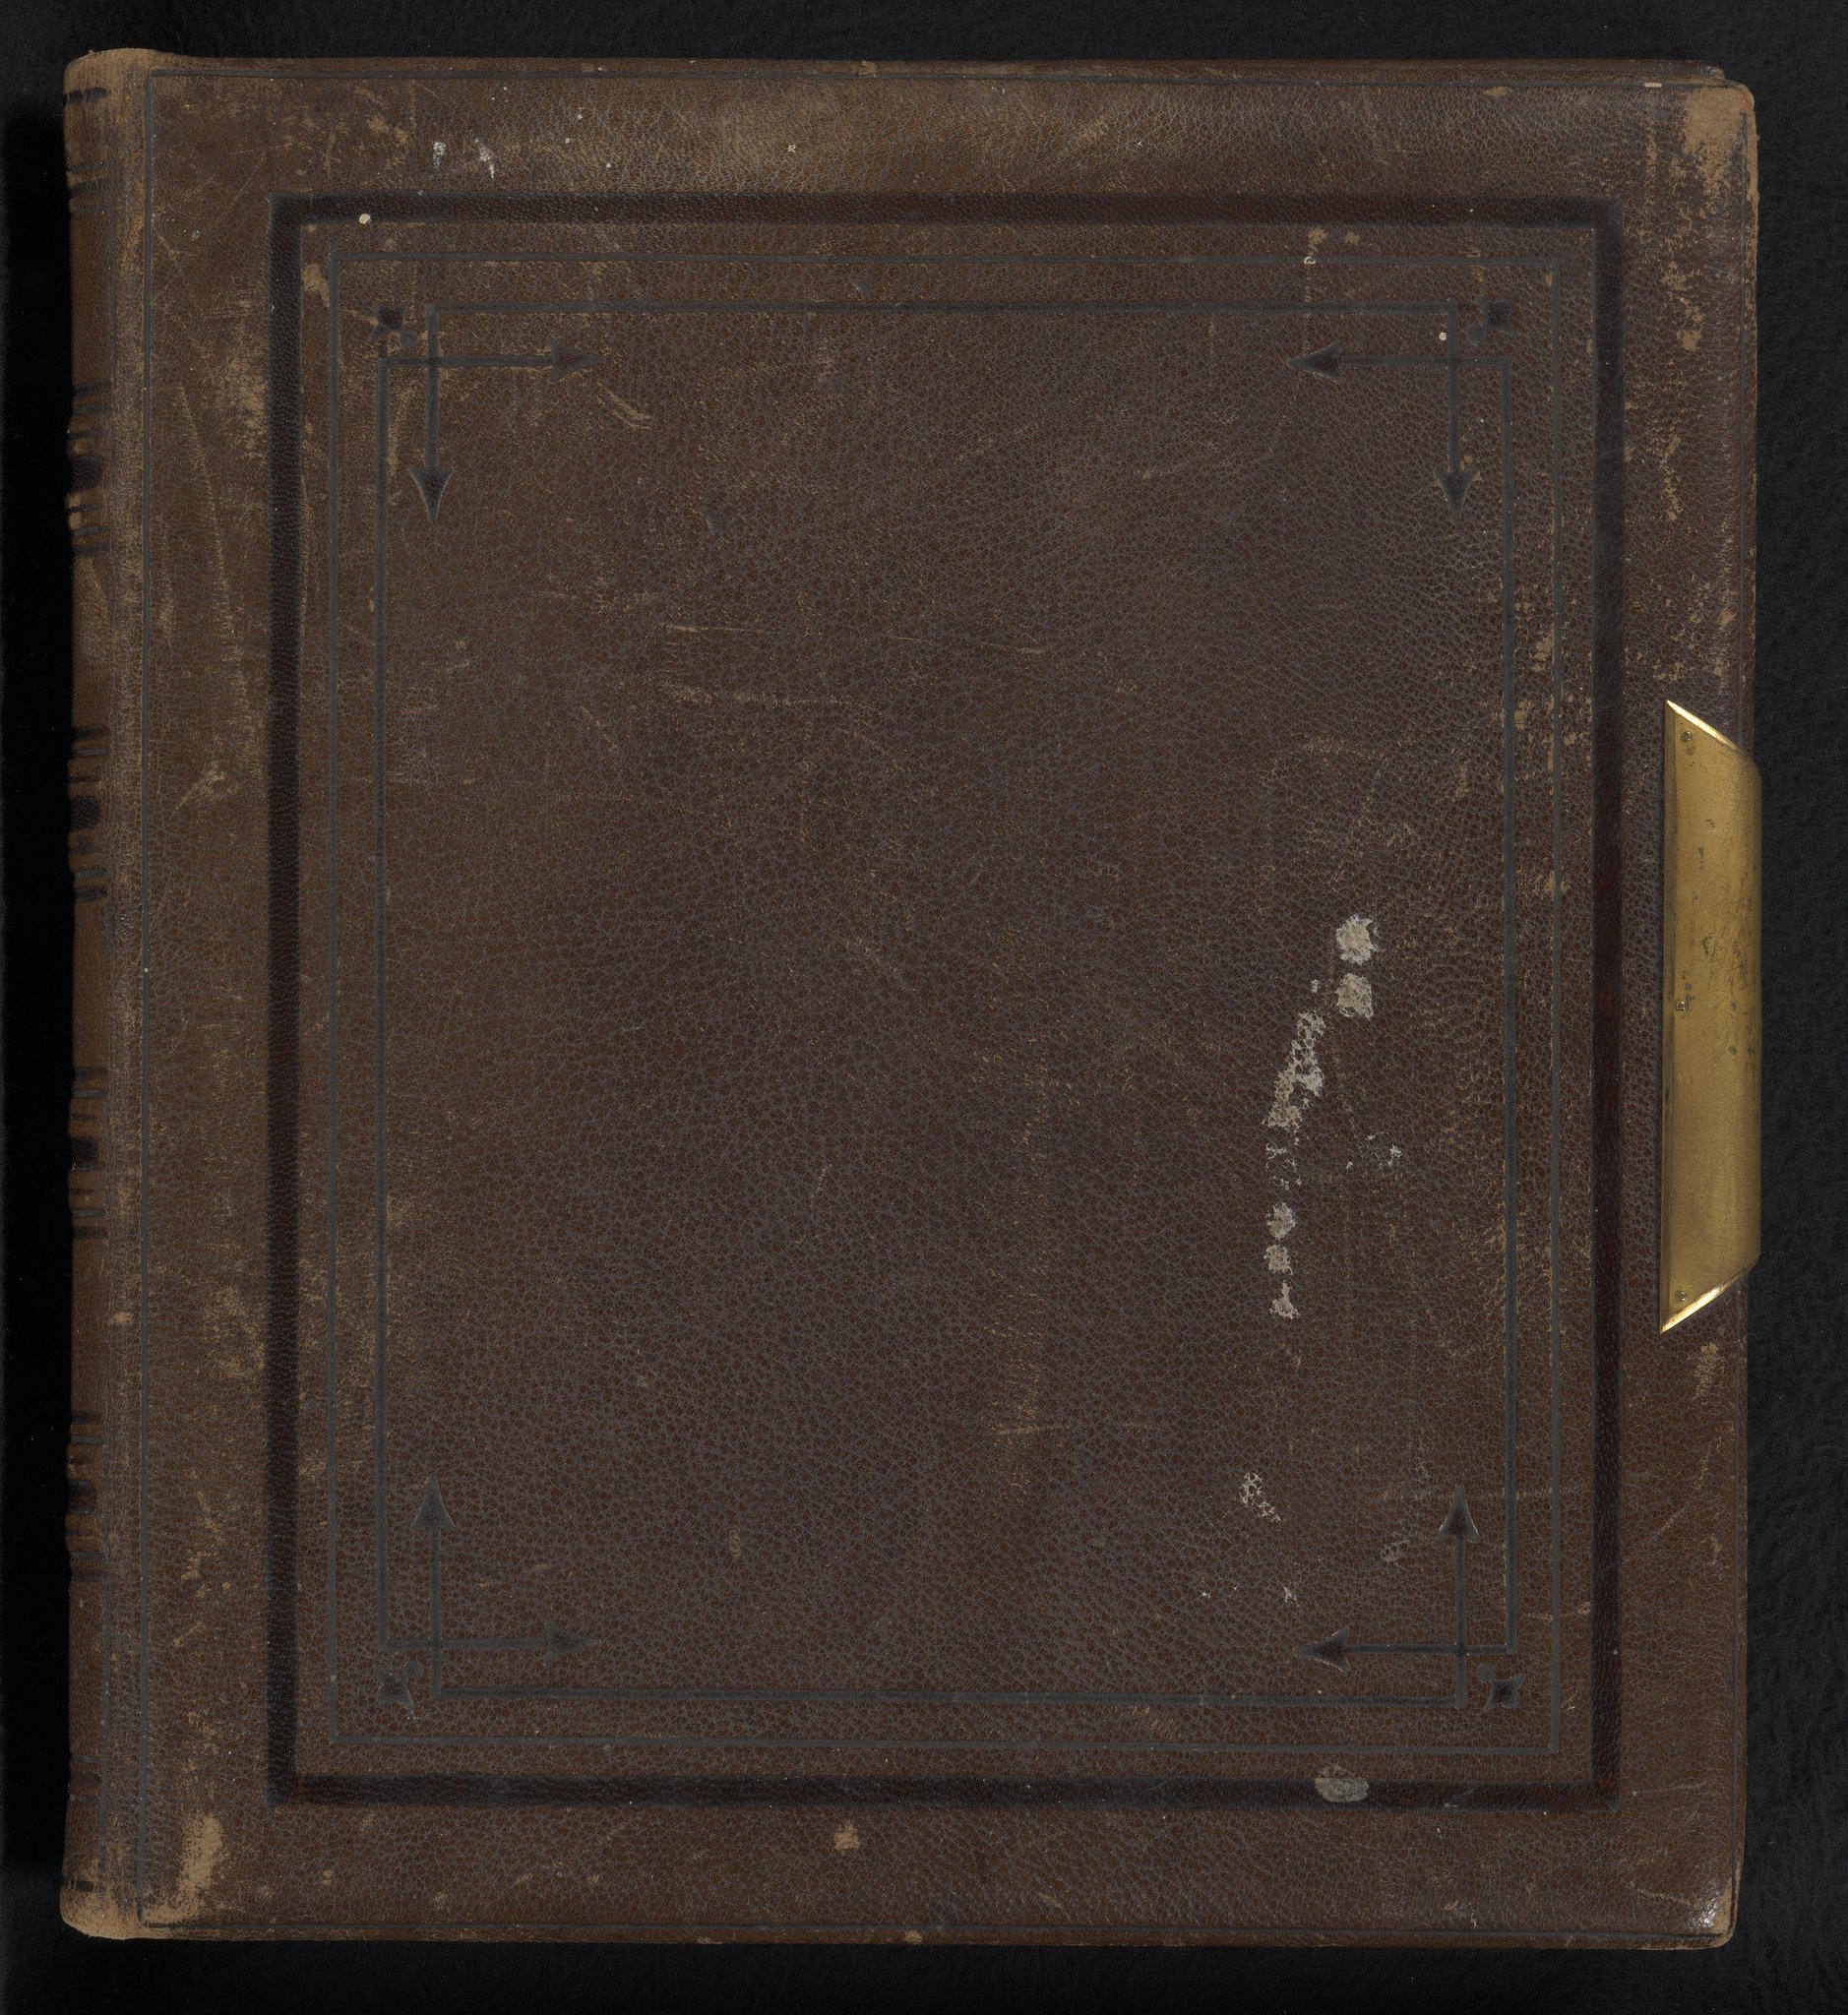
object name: photograph album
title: Album met 30 bladen met foto's en/of met de hand gemaakte randversieringen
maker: Anonymous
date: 1860-1875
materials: cardboard, paper, photographic support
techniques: albumen print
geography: united kingdom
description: Fotoalbum met leren omslag en 52 bladen met foto's en aquarelschilderingen. De foto's betreffen gezichten op verschillende villa's en bruggen in het Engelse en Schotse landschap en portretten van Britse personen. De aquarelschilderingen zijn om de foto's geschilderd en beelden verschillende planten en vogels uit. Op sommige pagina's staan slechts aquarelschilderingen, zonder foto's.